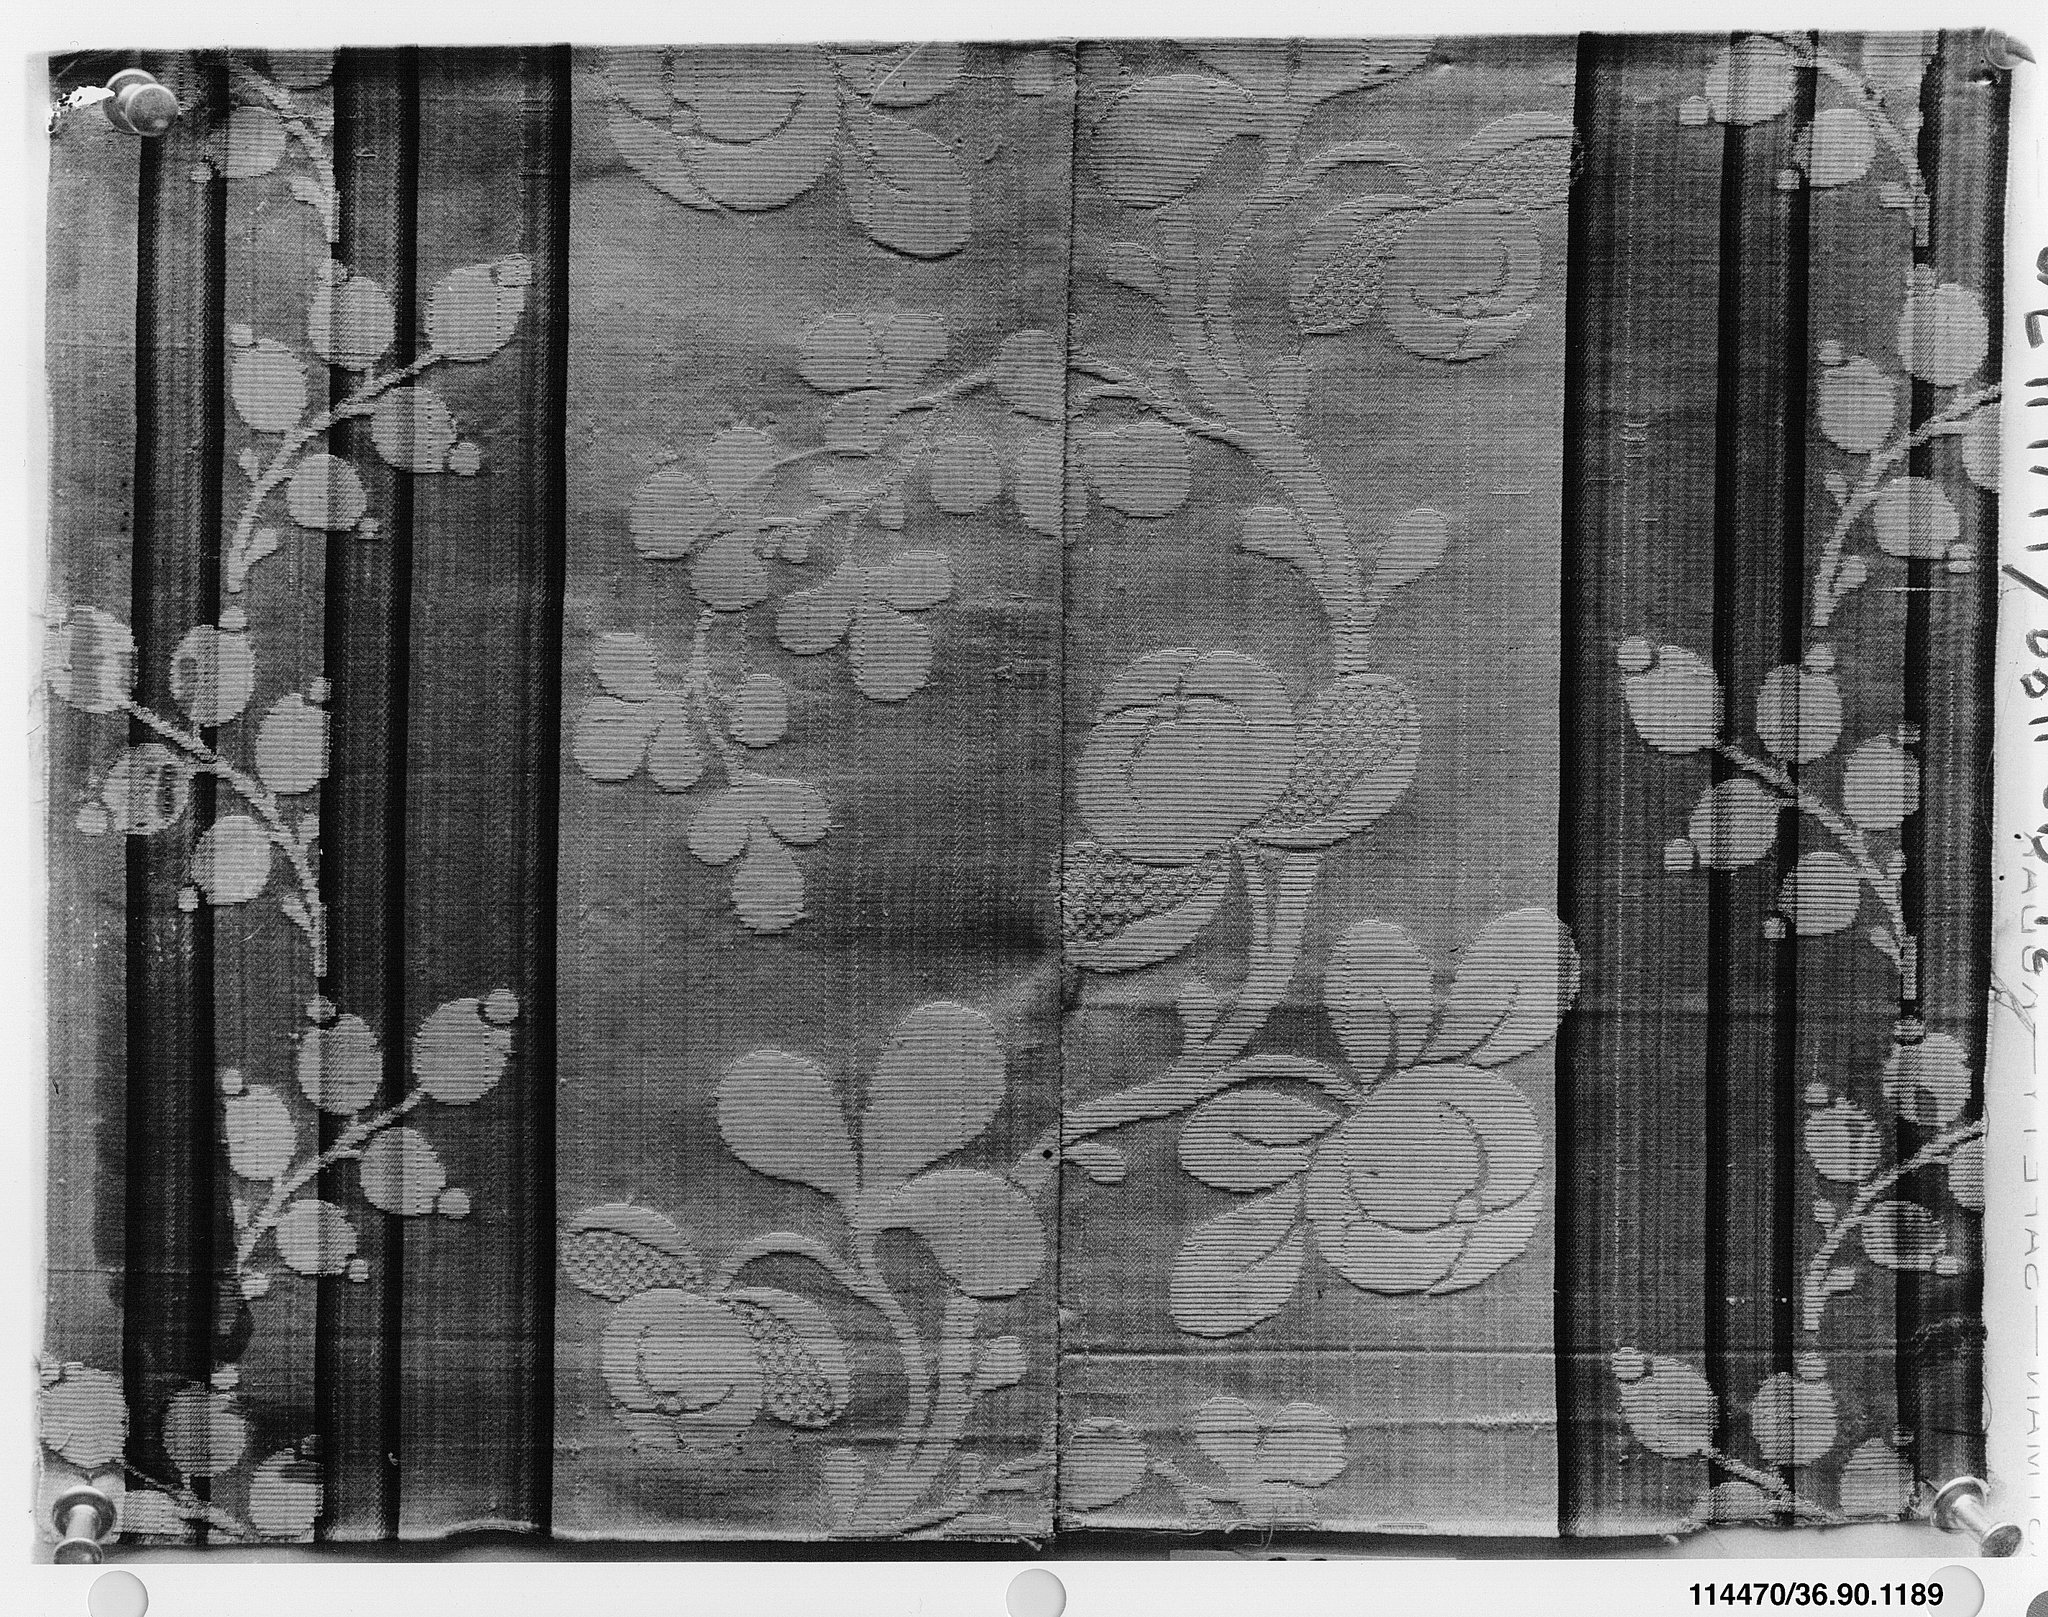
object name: piece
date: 1801-1900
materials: silk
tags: flowers,leaves